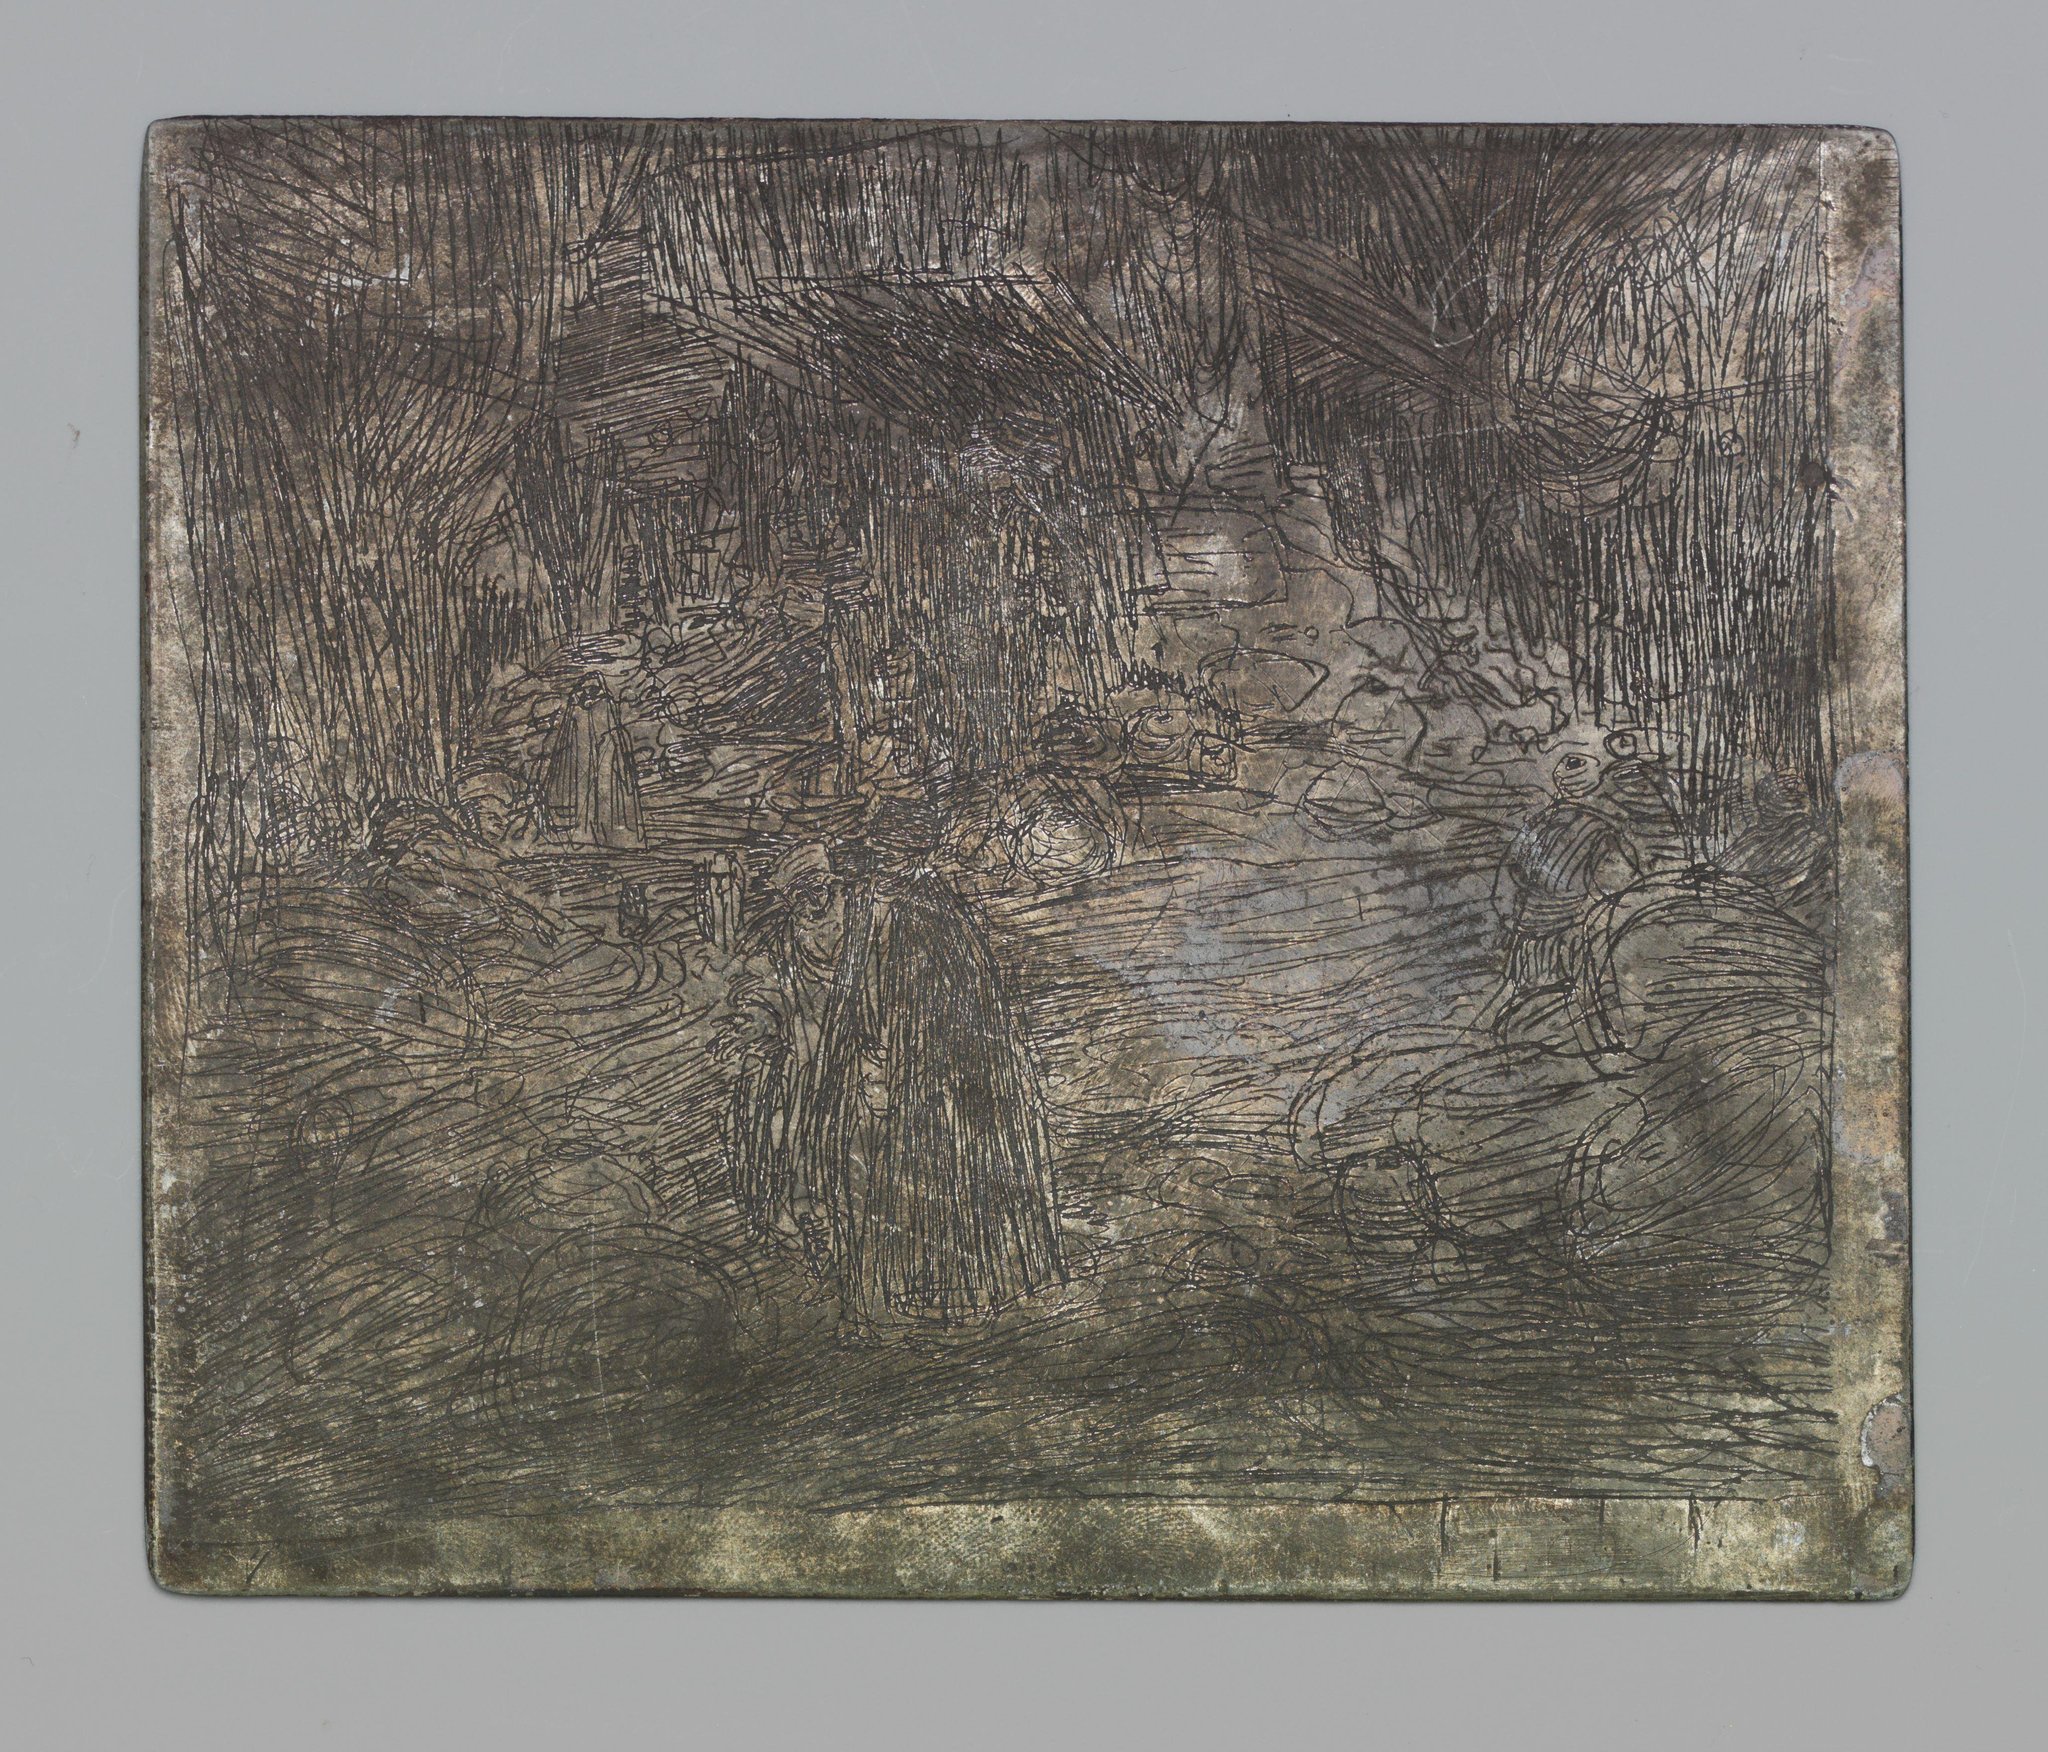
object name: zinkplaat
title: Het verlaten van de tempel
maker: marius bauer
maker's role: draughtsman, print maker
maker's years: 1867-1932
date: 1924-1932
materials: zinc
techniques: etching